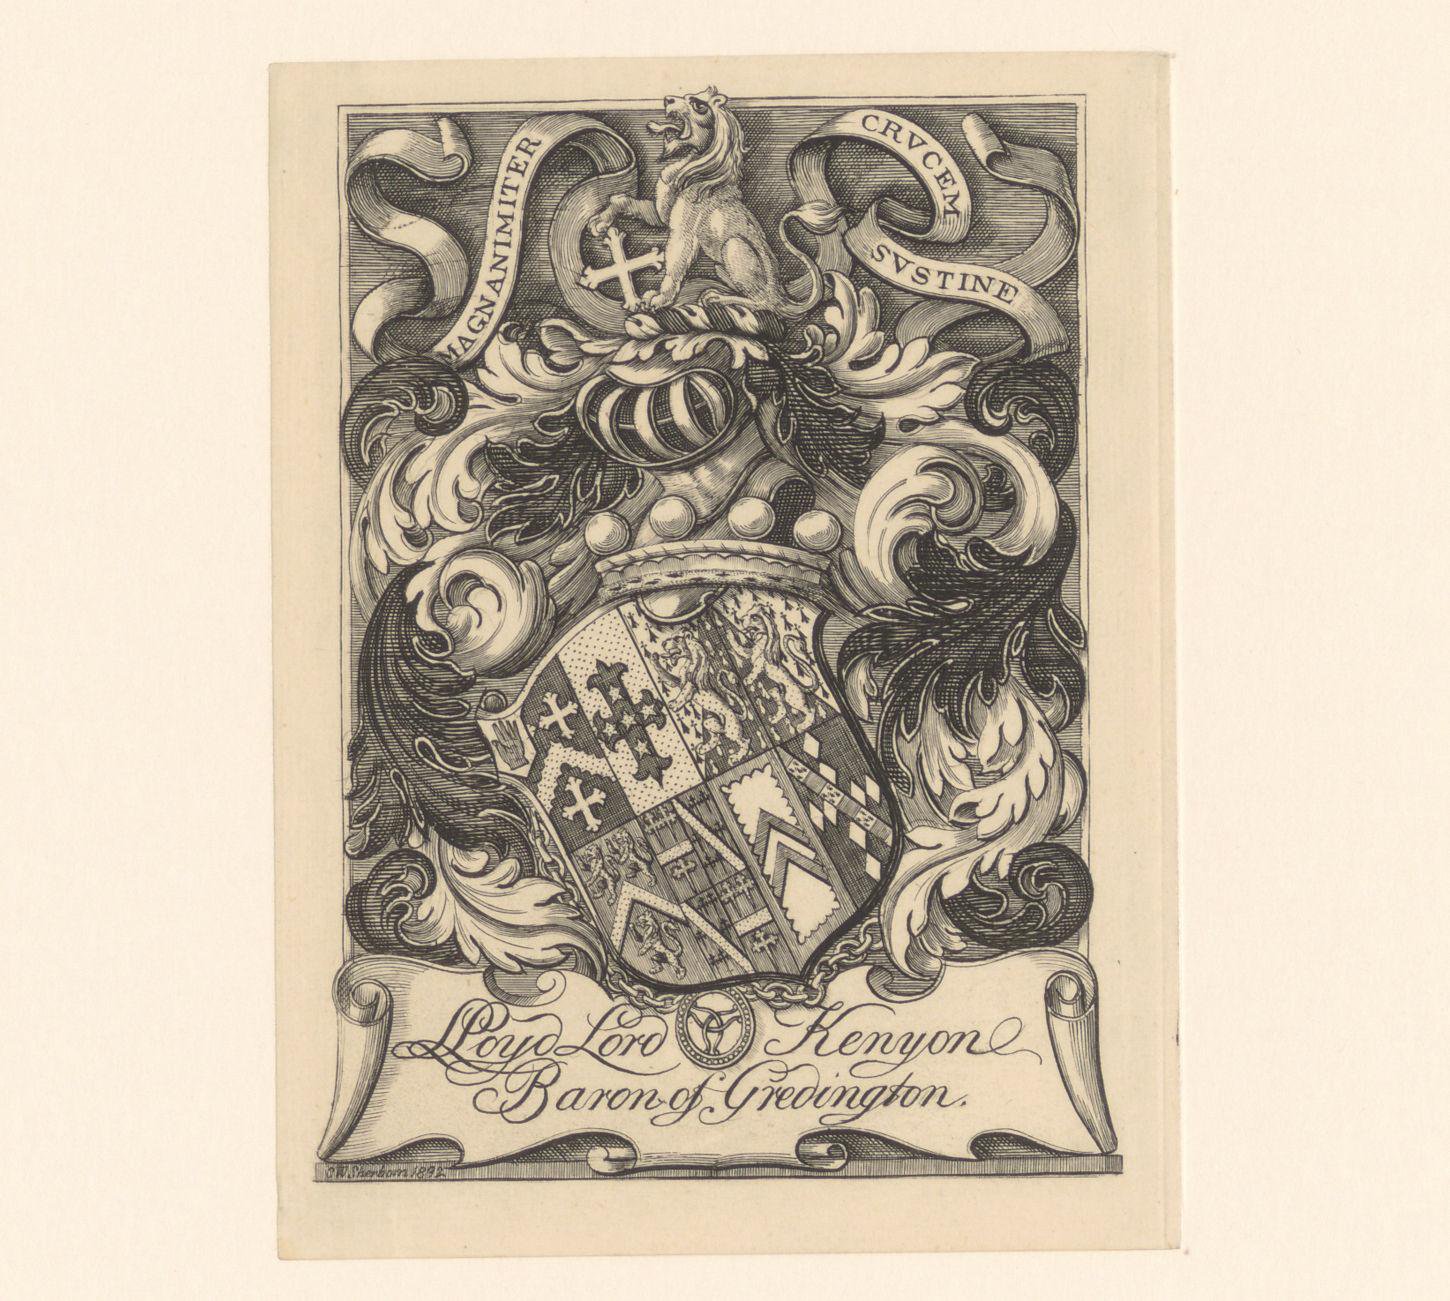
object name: bookplate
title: Ex libris van Lloyd Tyrell-Kenyon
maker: charles william sherborn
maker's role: print maker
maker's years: 1831-1912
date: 1892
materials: paper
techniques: engraving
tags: politician, foliage ~ ornament, 'laub- und bandelwerk' ~ ornament, beasts of prey, predatory animals: lion, armorial bearing, heraldry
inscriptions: collector's mark: Lugt 2228